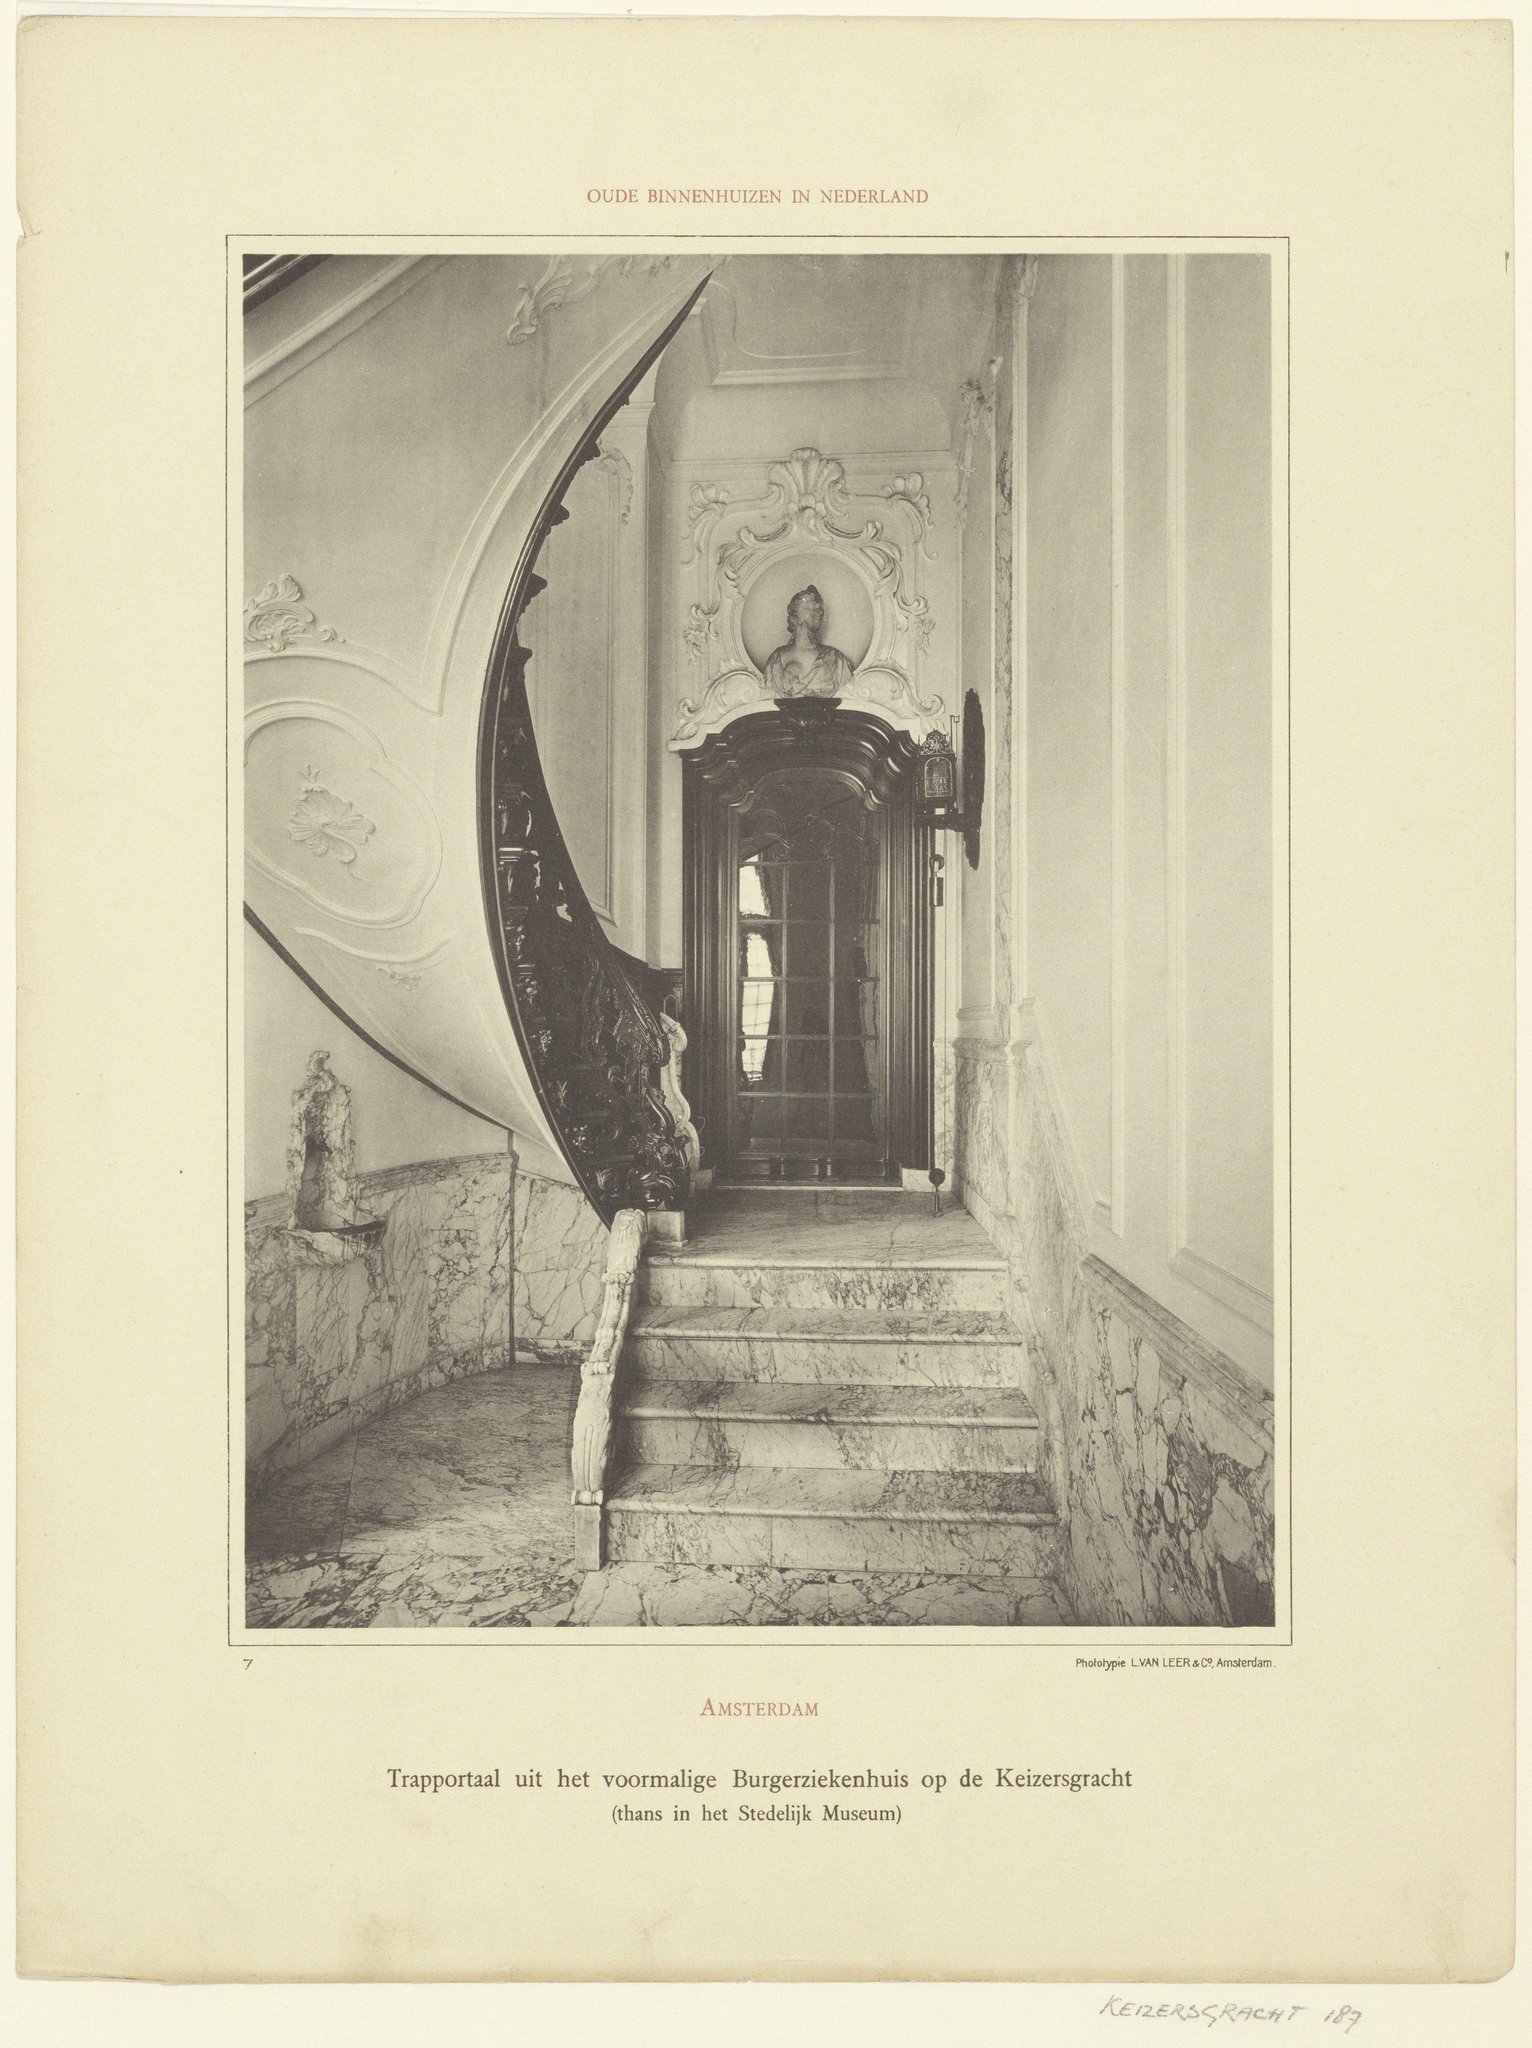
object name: architectural element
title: Onderdelen van het trapportaal uit het pand aan de Keizersgracht 187 te Amsterdam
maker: Anonymous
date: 1740-1760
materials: wood, marble